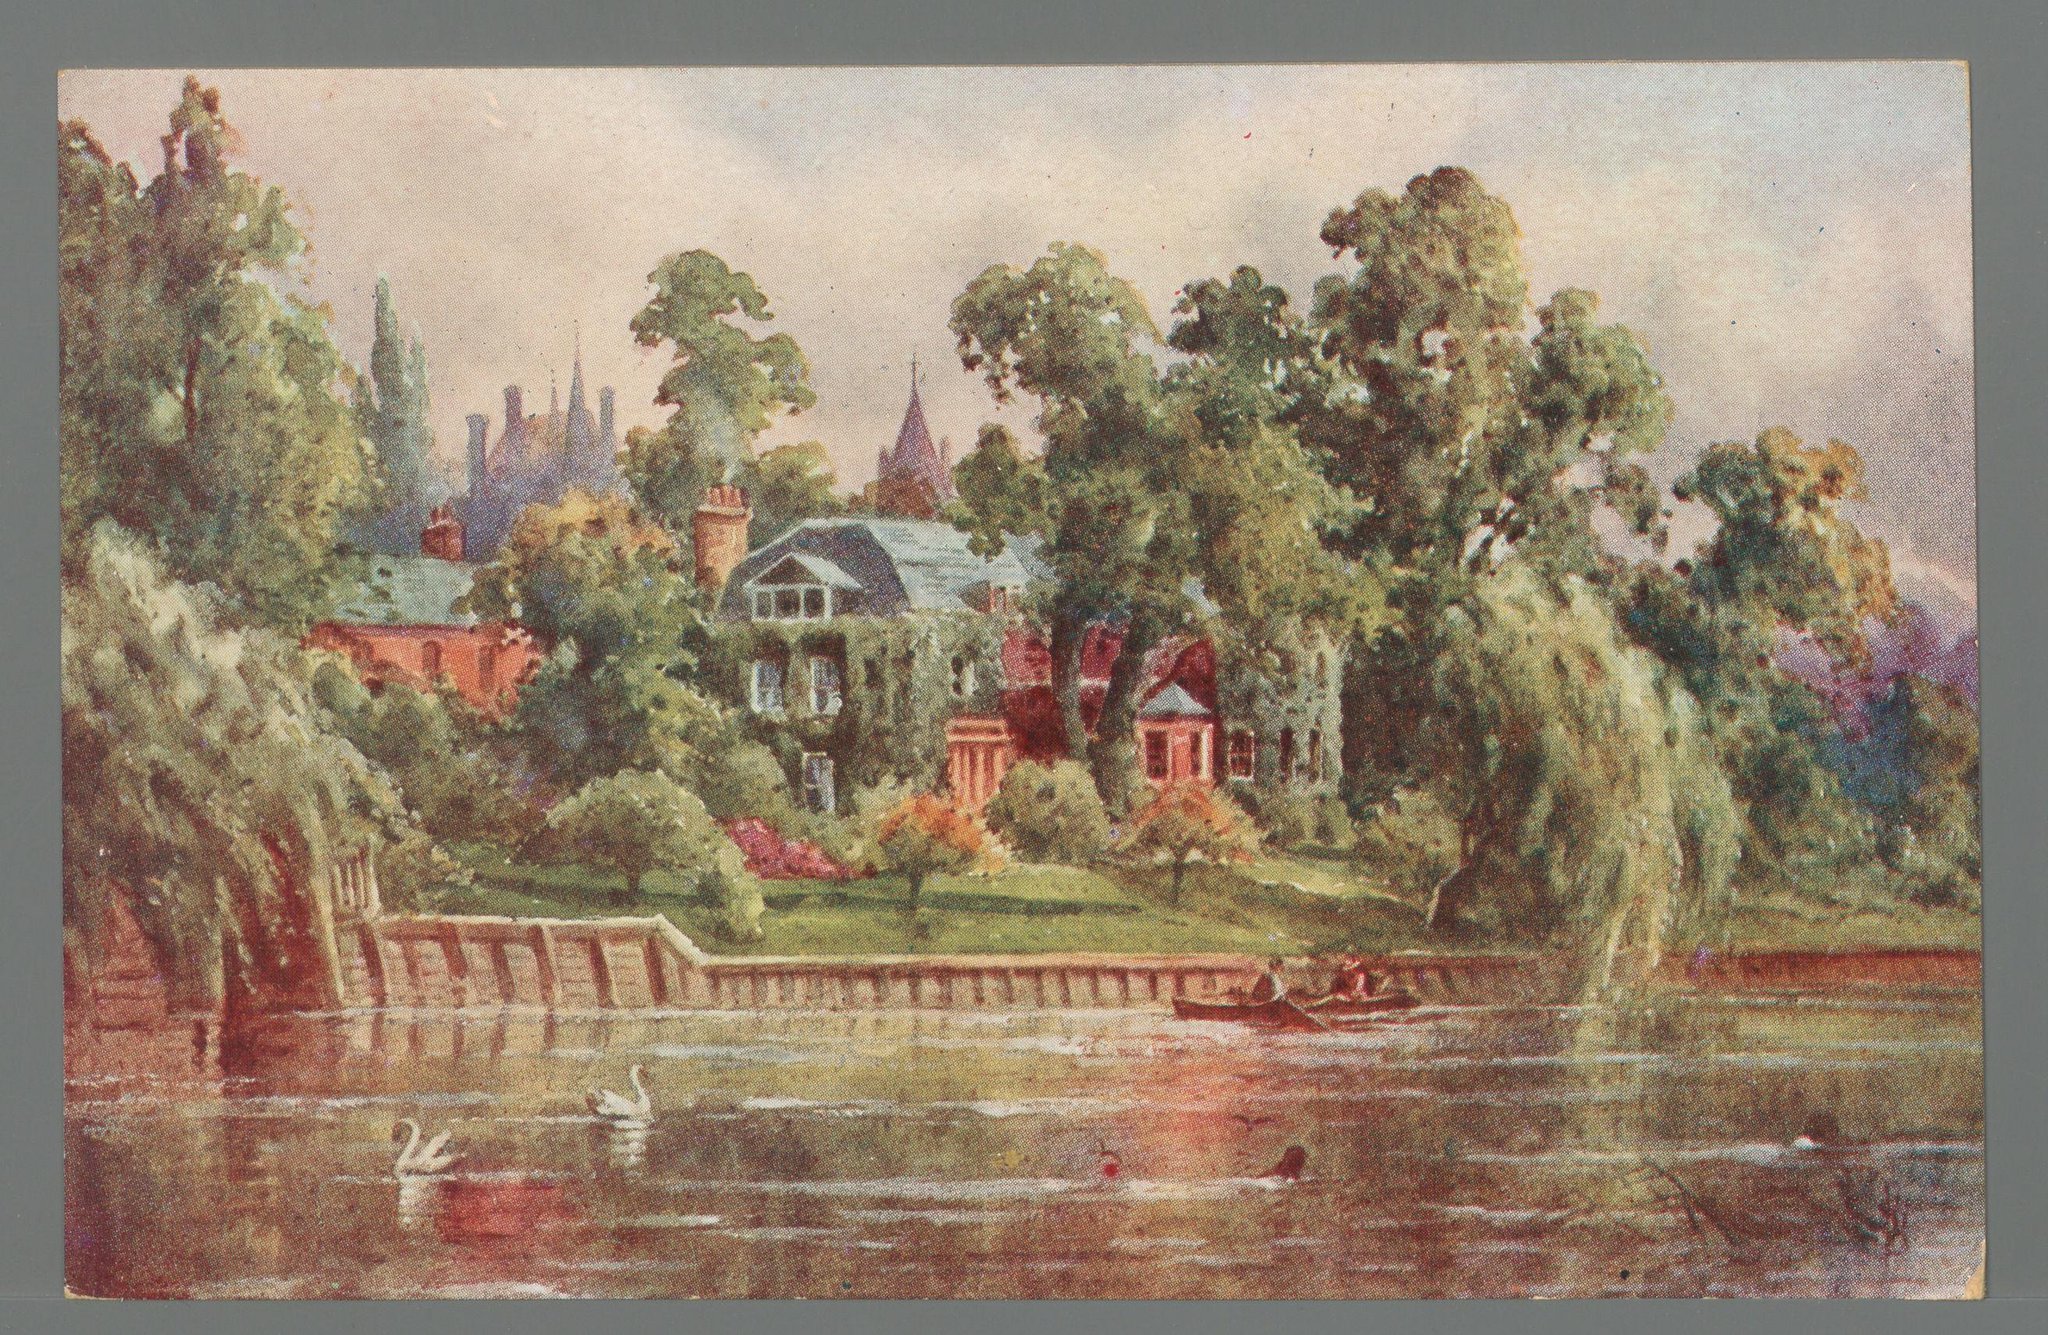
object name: reproduction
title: Buccleuch House, Richmond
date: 1902-1930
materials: cardboard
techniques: color autotype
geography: richmond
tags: canals, waters (in city), villa, thames